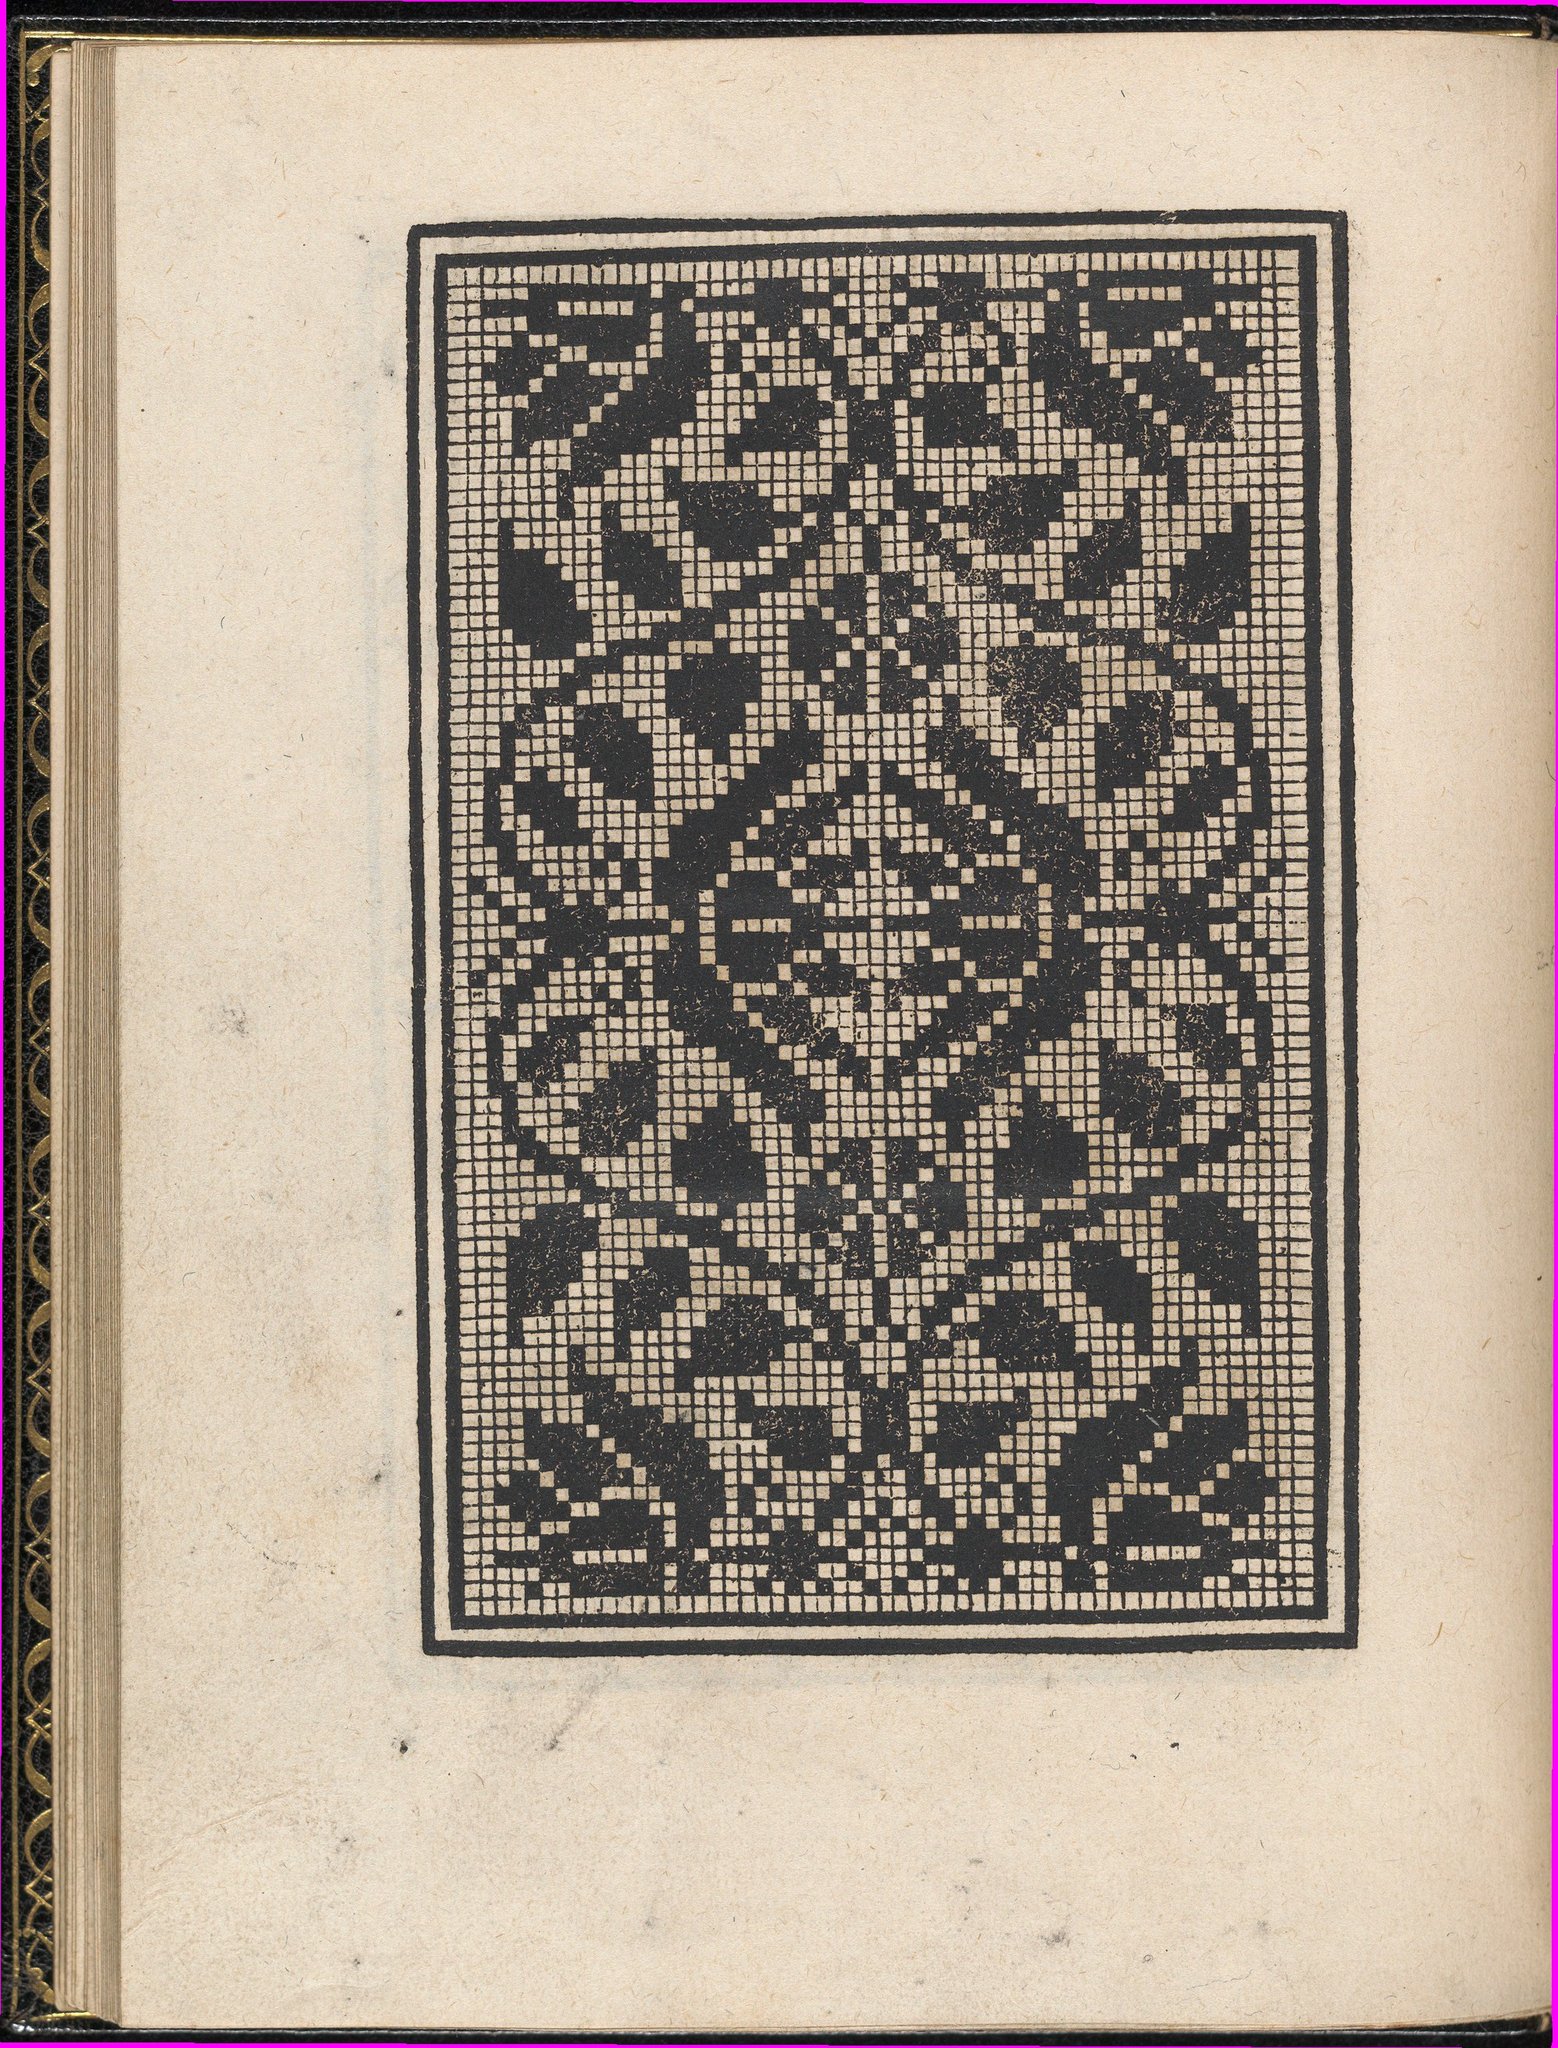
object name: book print ornament architecture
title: Page from Ein new kunstlich Modelbuch...(Page 20v)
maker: peter quentel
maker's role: publisher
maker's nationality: german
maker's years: 1500-1550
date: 1544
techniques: woodcut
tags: flowers